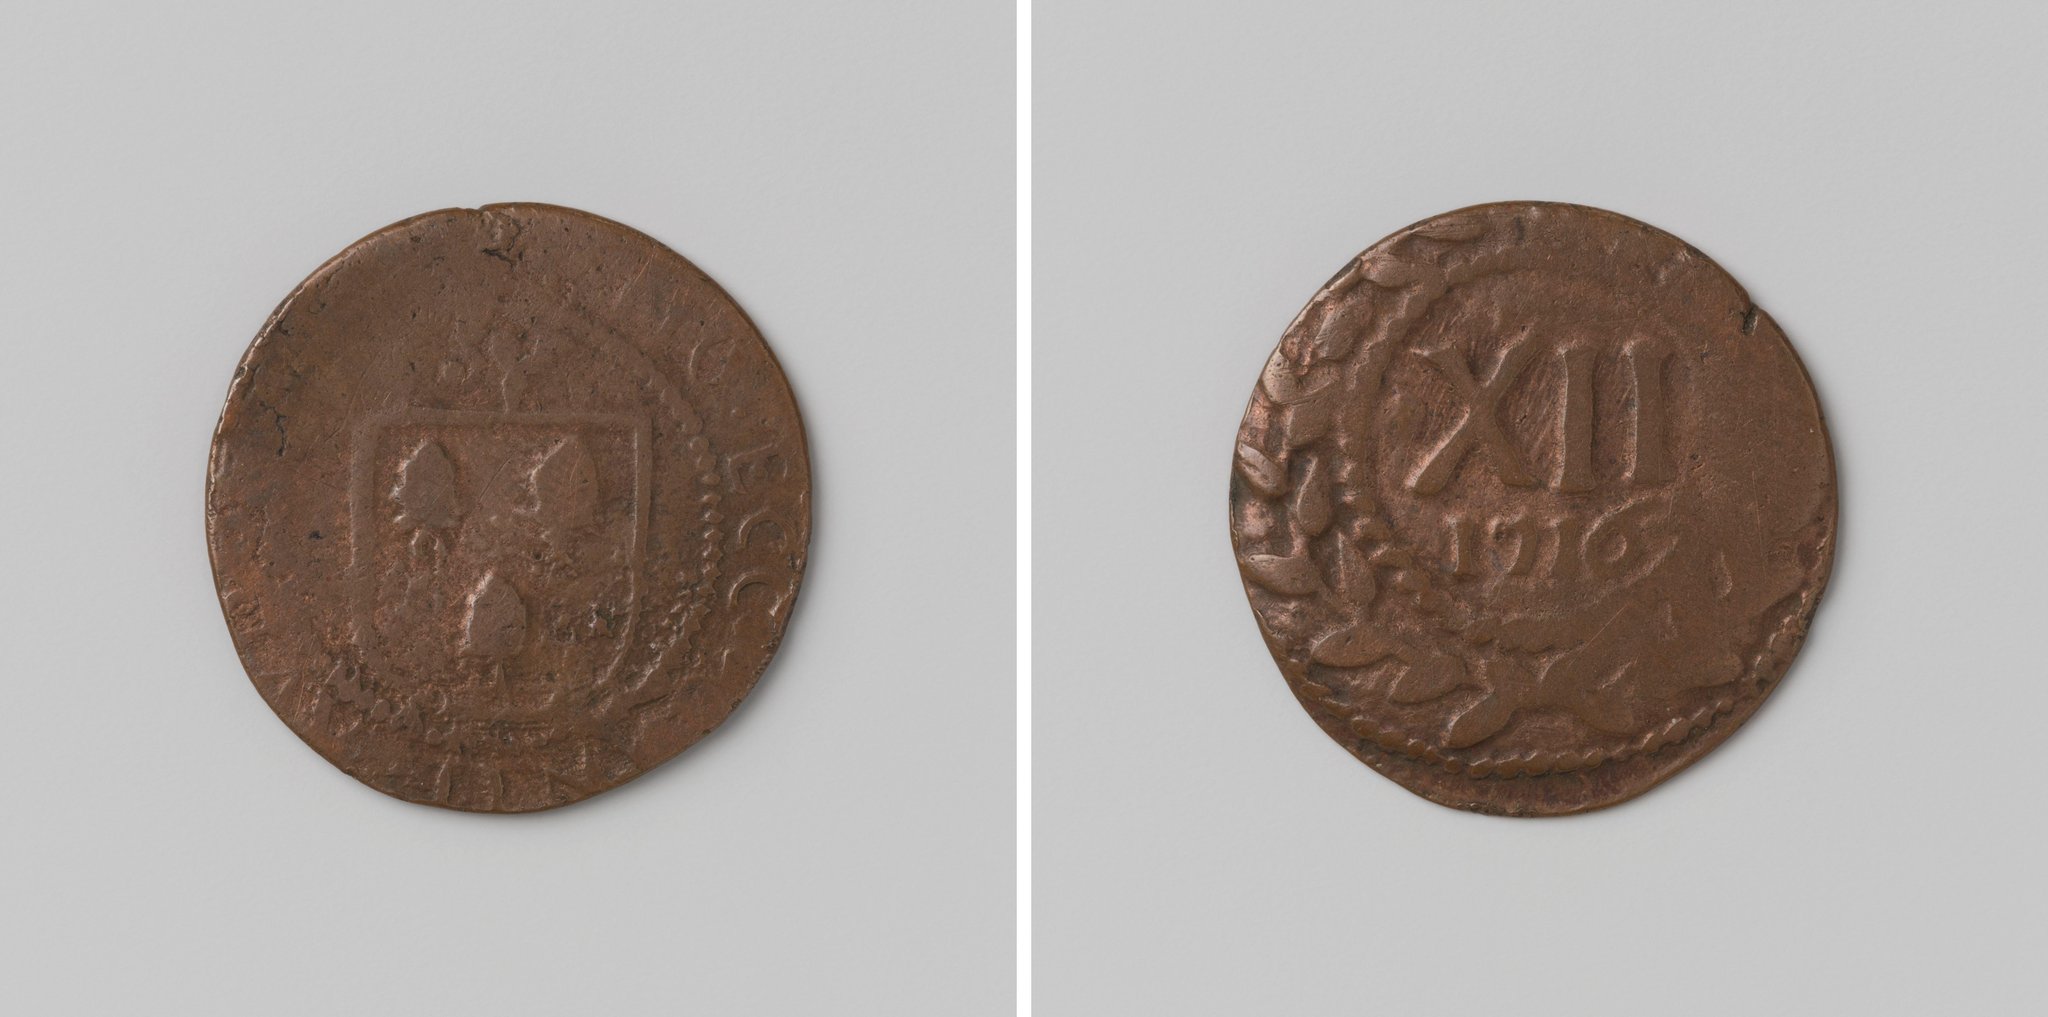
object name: devotional medal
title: Kerk van St. Omer, avondmaalspenning met no. 12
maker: Anonymous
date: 1716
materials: copper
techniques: striking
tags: saint-omer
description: Koperen penning. Voorzijde: wapenschild op bisschopsstaf binnen omschrift. Keerzijde: Romeins cijfer XII boven jaartal binnen bladerkrans